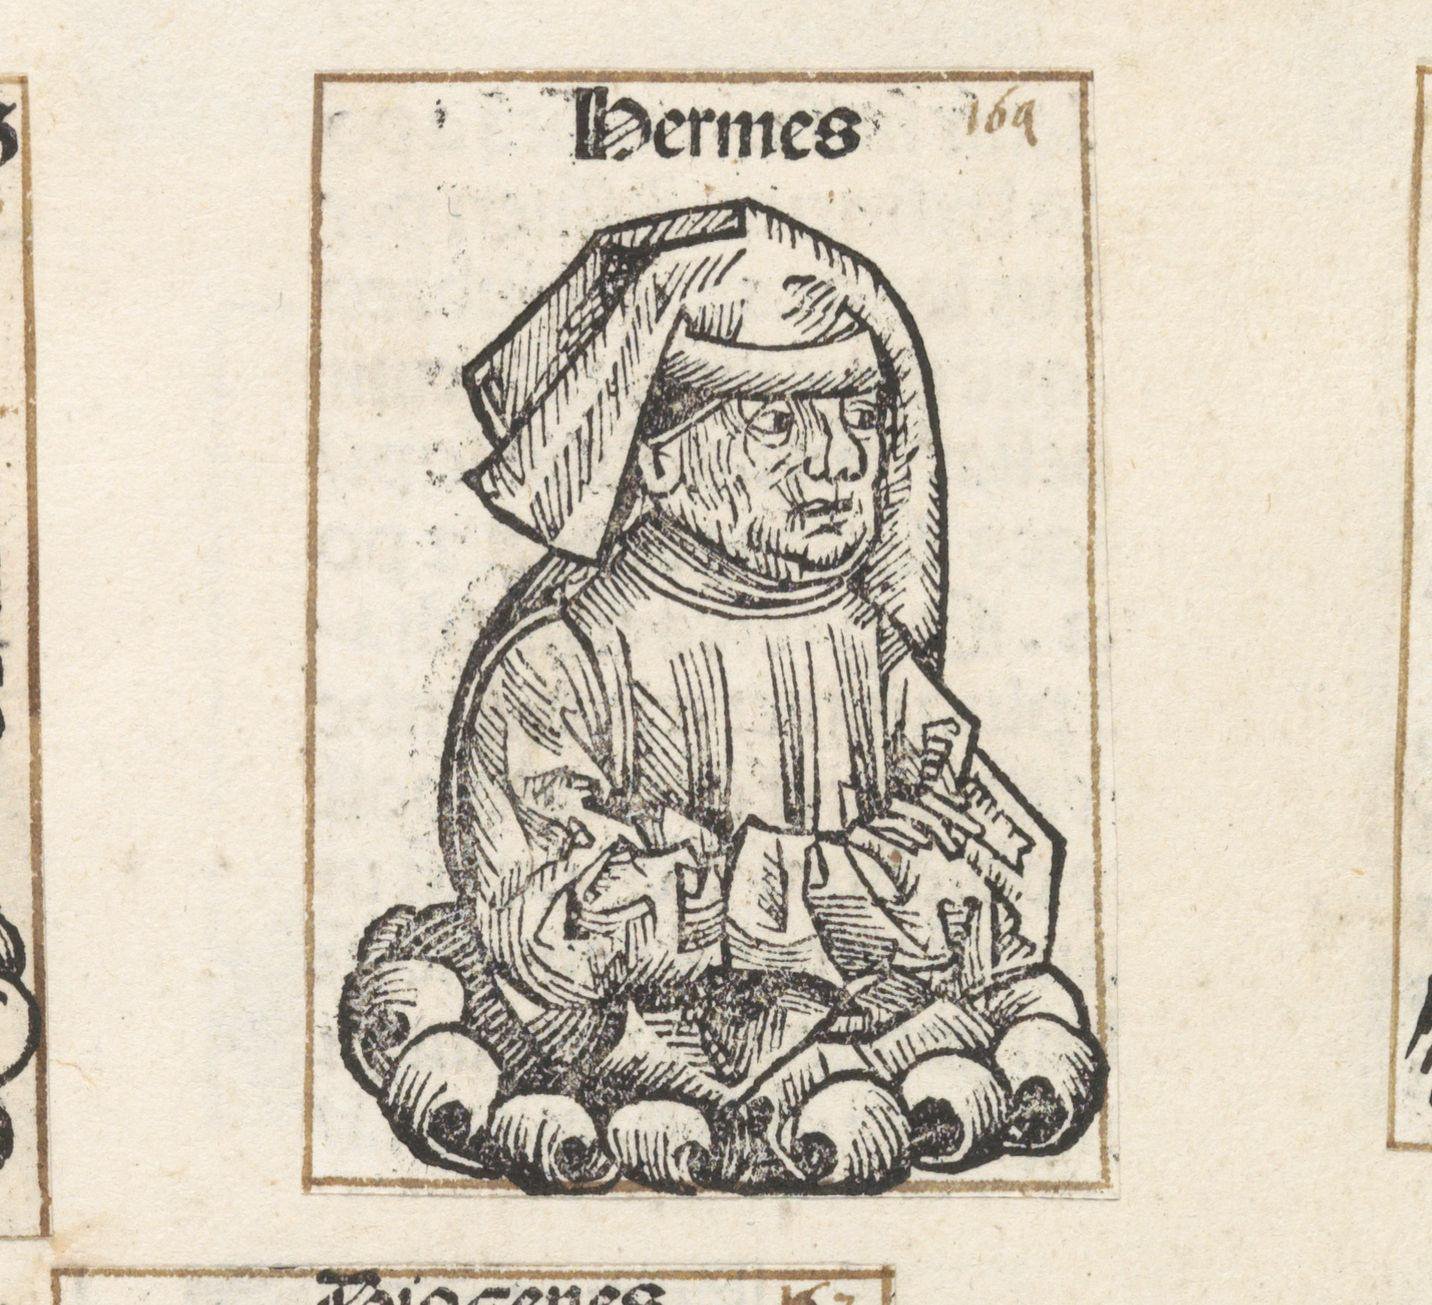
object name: book illustration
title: Hermes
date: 1493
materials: paper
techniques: letterpress printing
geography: nuremberg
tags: male persons from classical history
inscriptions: inscription: ‘164’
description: Een bloemkelk met een man. Hij draagt een kaproen en heeft zijn handen in zijn mouwen gestoken. De tekst identificeert hem als de mythische filosoof Hermes. De prent maakt deel uit van een album.